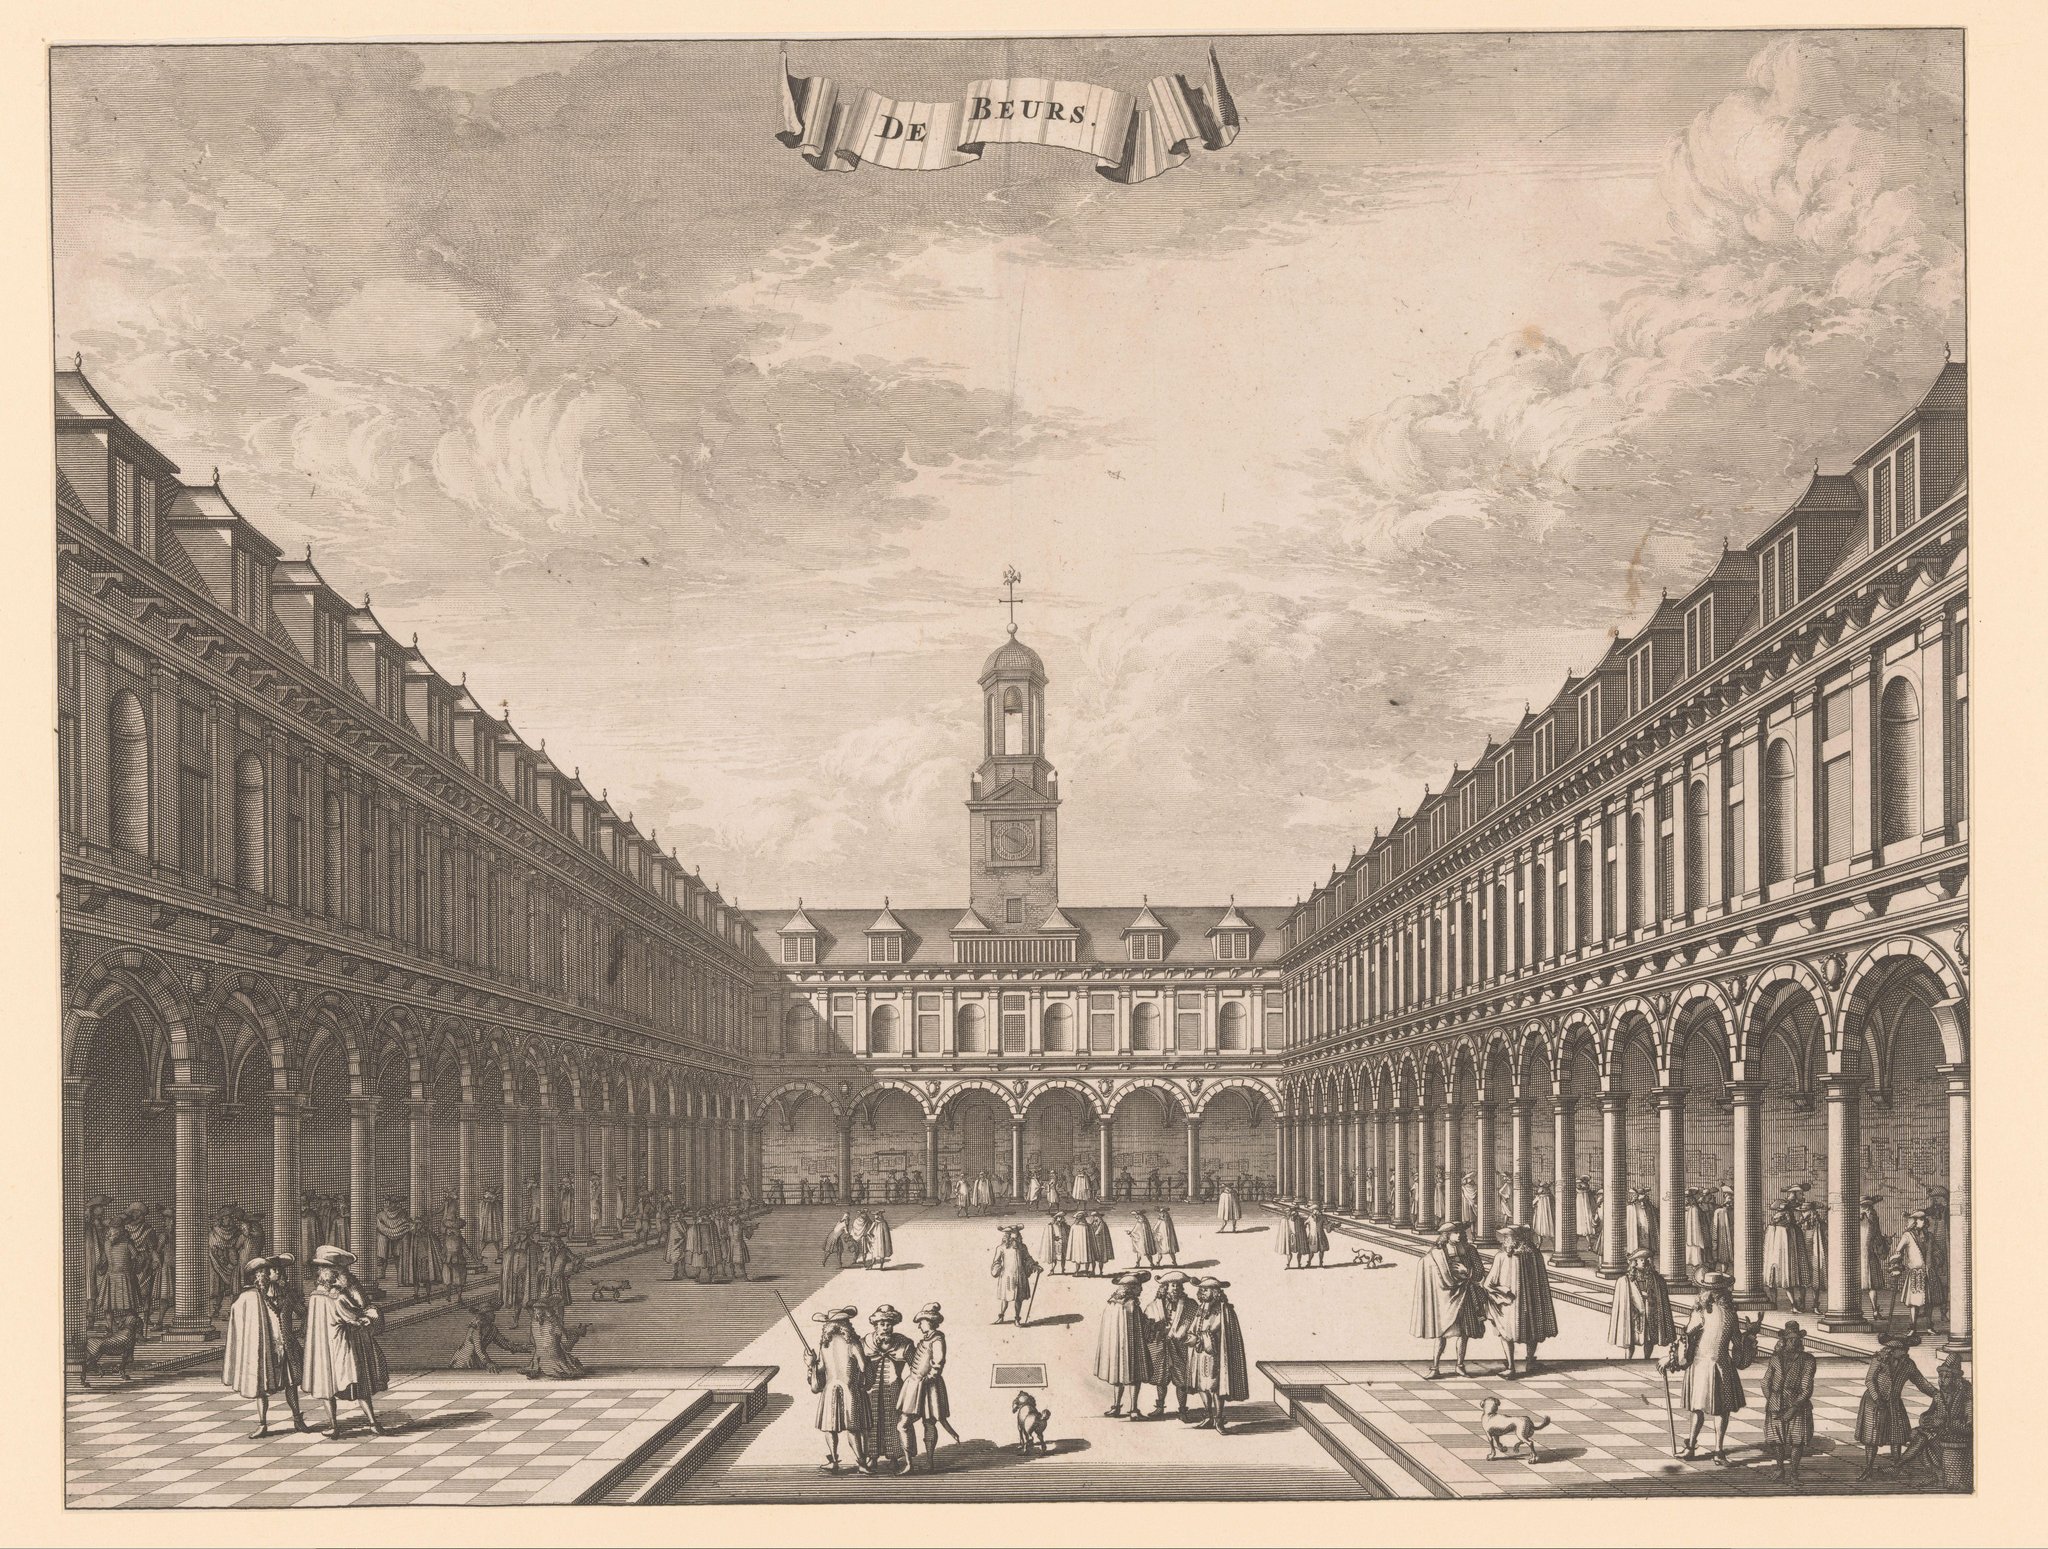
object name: book illustration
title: De Beurs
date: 1693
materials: paper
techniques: engraving, etching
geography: amsterdam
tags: tower, clock tower ~ monumental adornment, stock exchange, stock-market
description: Prent uit: Commelin, Caspar. Beschryvinge van Amsterdam (...). 2 dln. Amsterdam: Abraham Wolfgang et al., 1693, dl. 2, p. 618-619. En in latere edities van dit werk (Amsterdam: Weduwe Aart Dircksz. Oossaan, 1694 en Amsterdam: Andries van Damme et al., 1726).